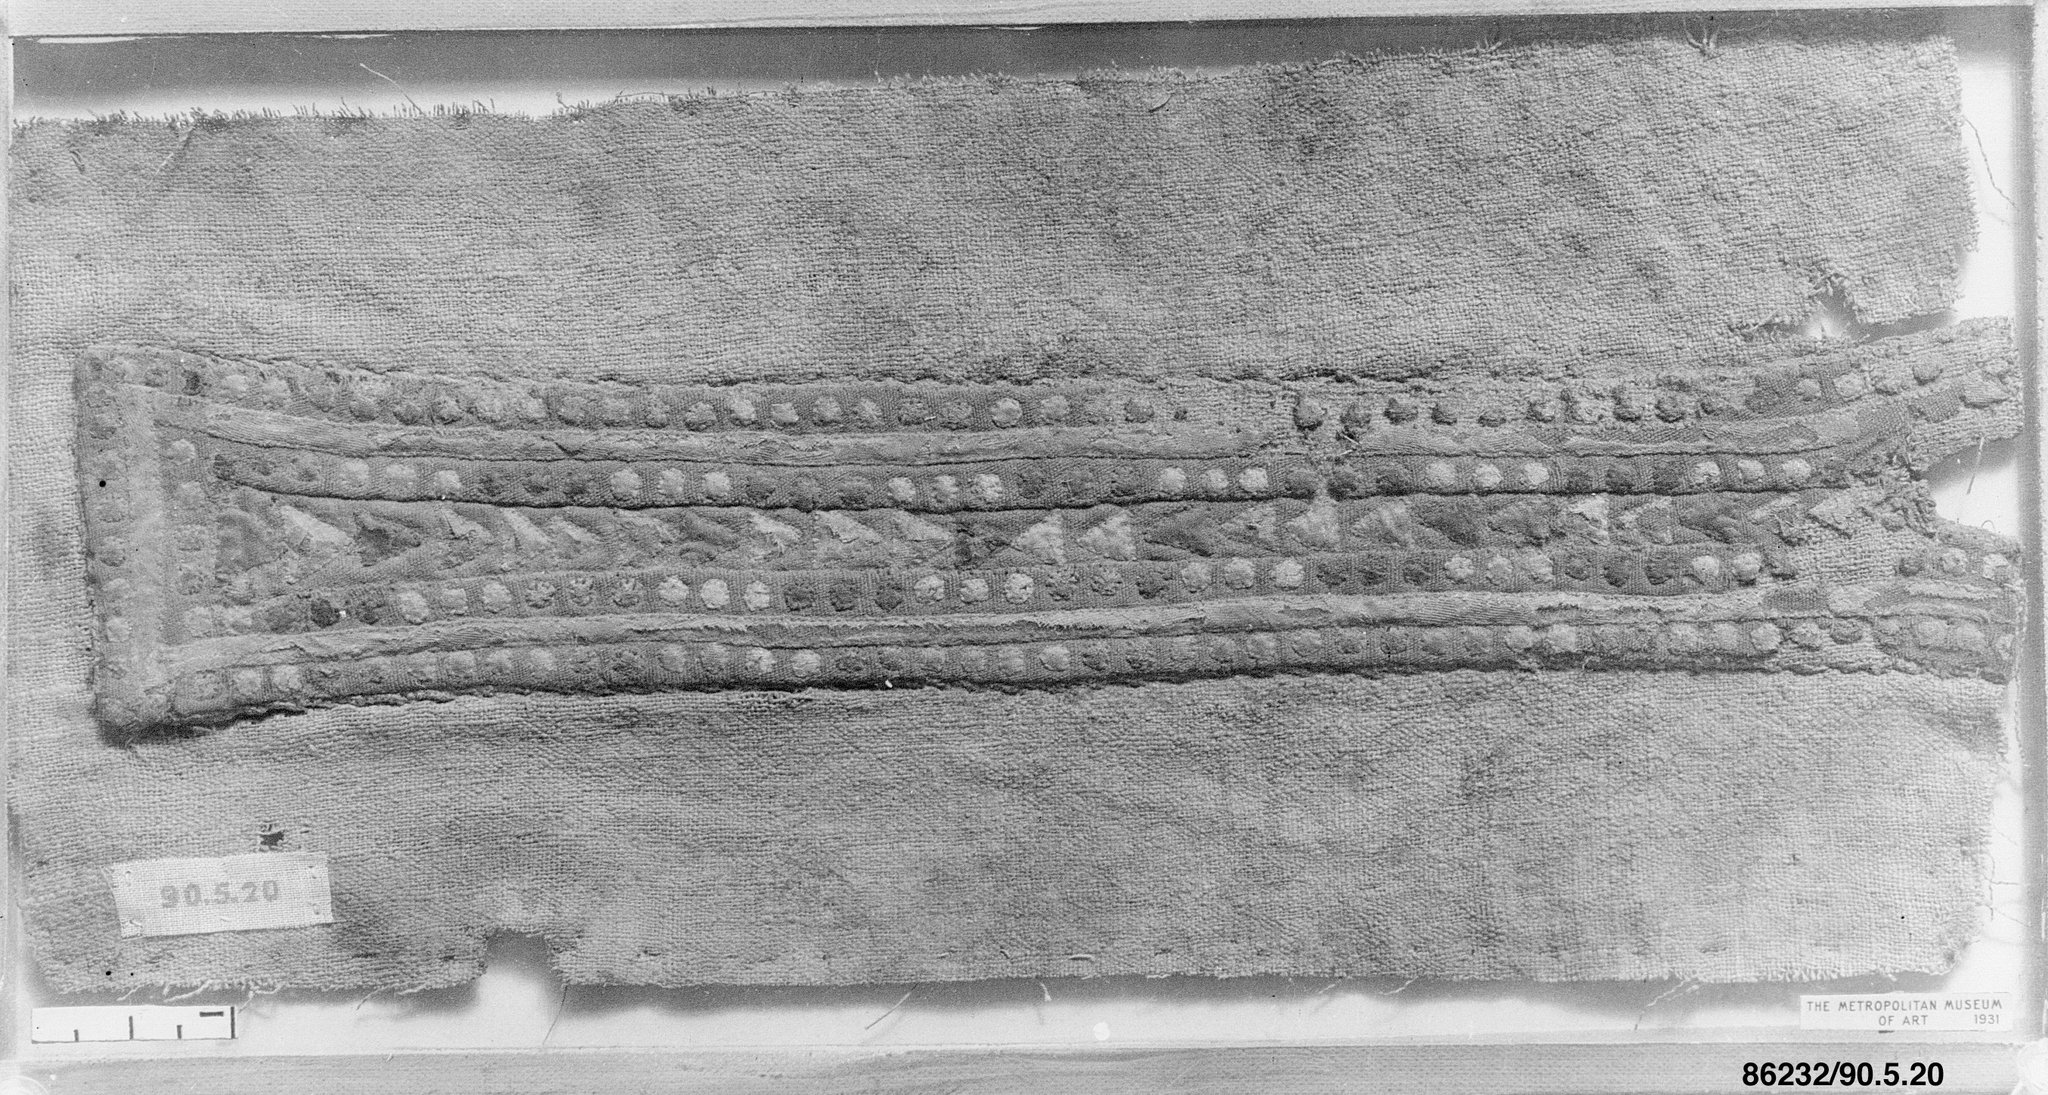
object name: textile fragment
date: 901-1000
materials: linen, silk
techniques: embroidery, weave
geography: egypt